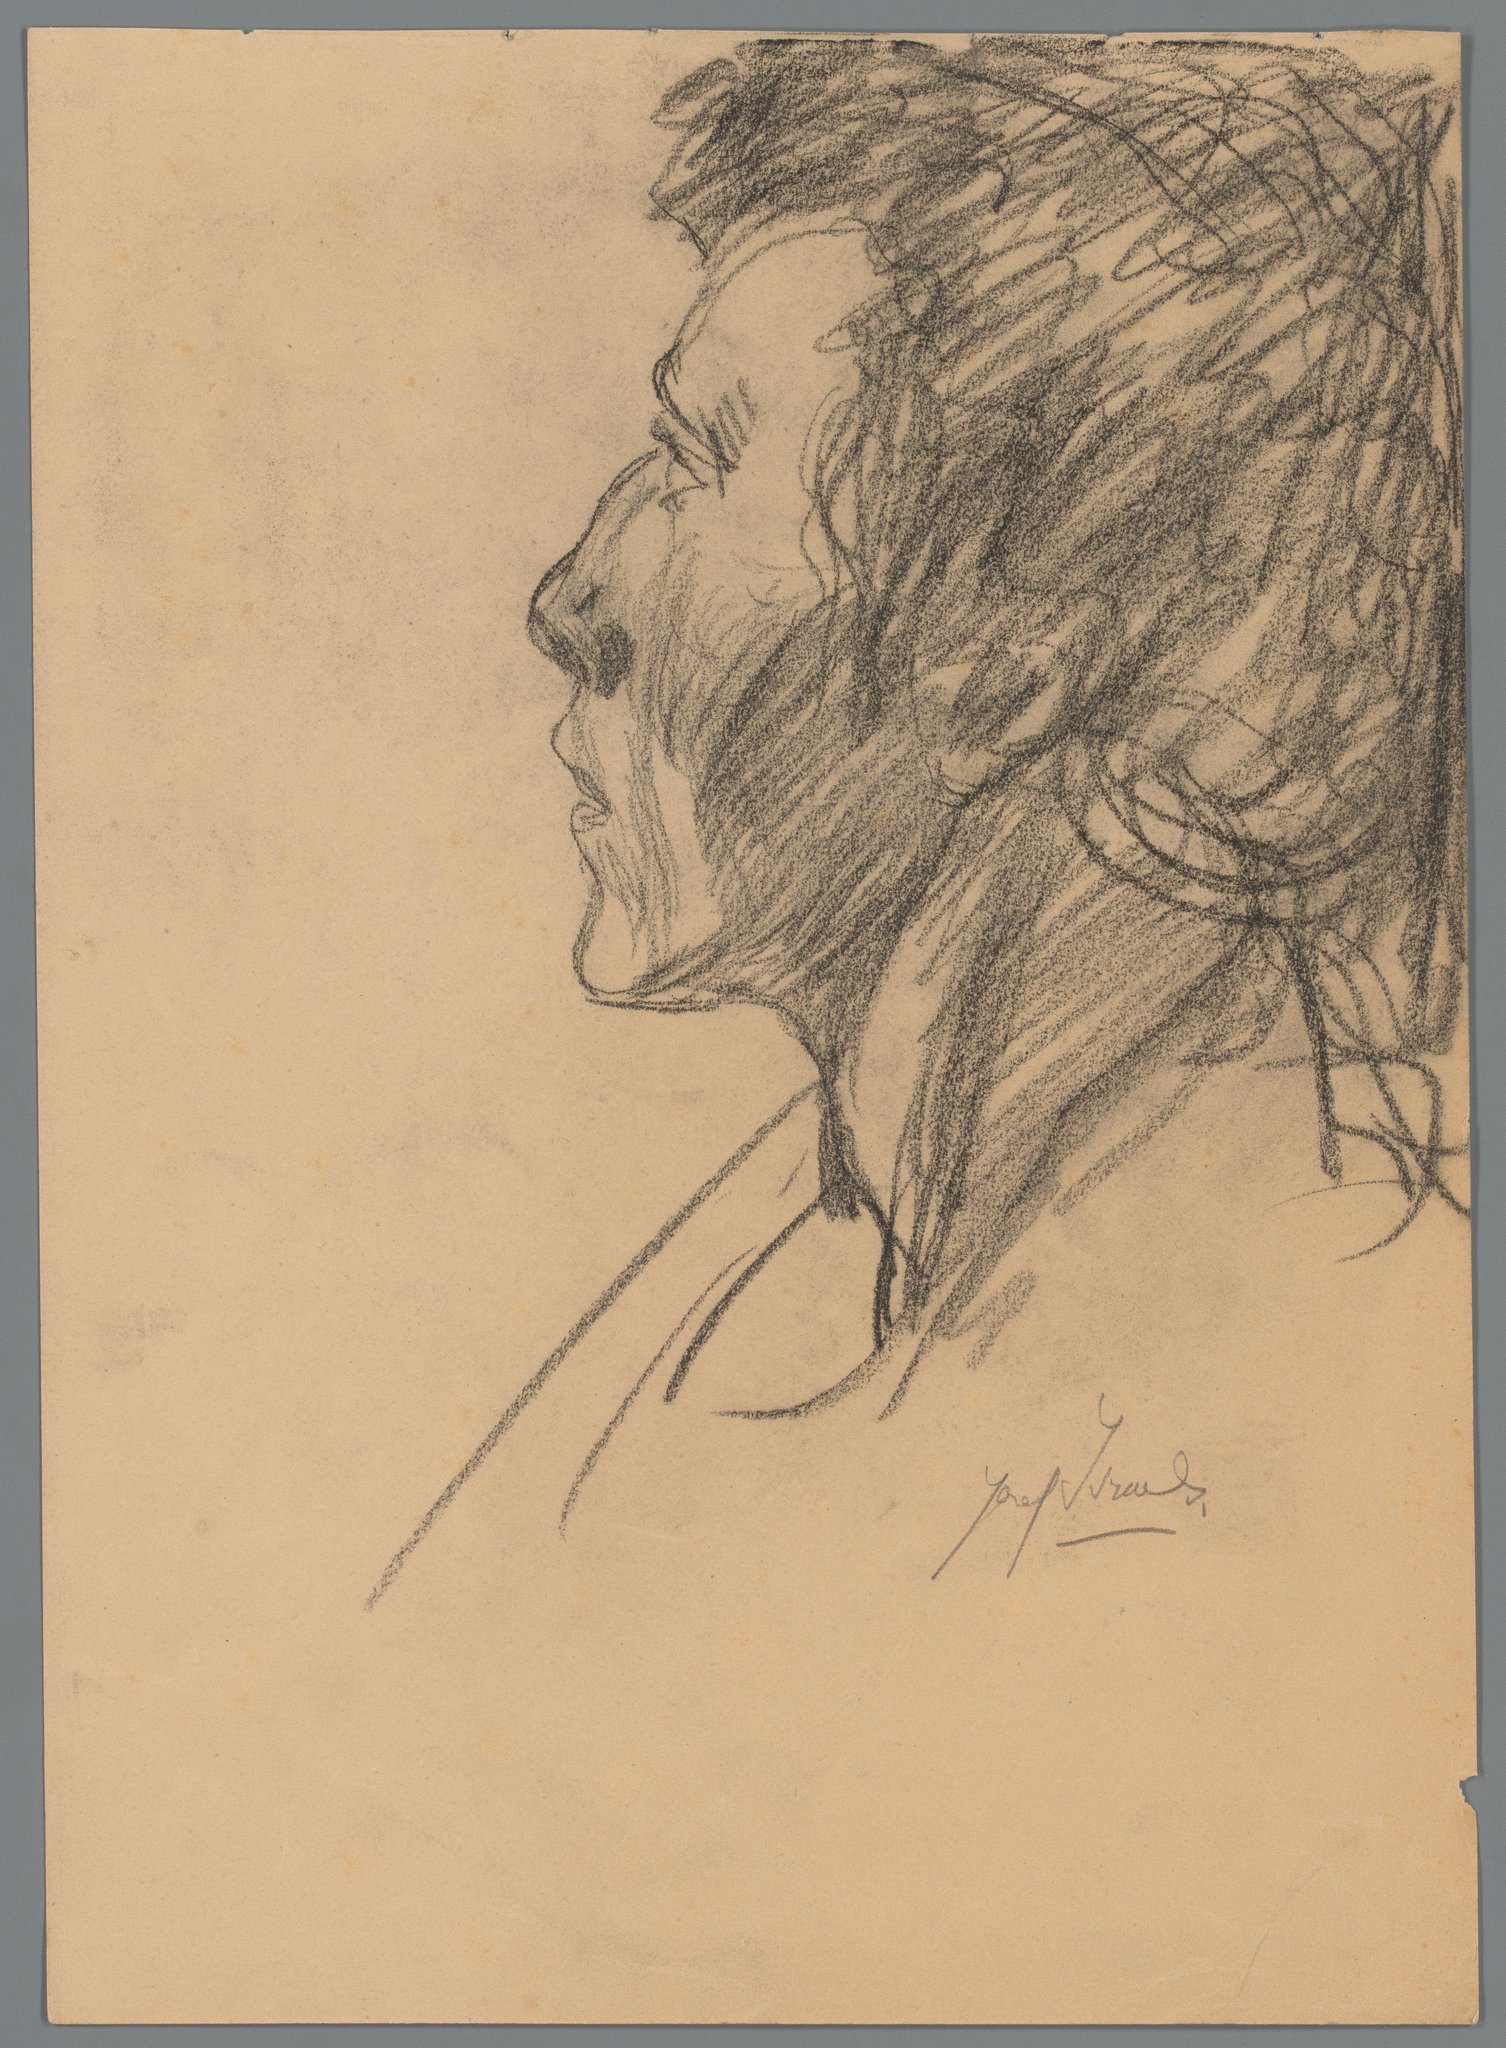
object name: drawing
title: Hoofd van David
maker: jozef israëls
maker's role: draughtsman, painter, print maker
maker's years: 1824-1911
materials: chalk, paper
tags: head (human), story of david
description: Voorstudie voor het schilderij 'David en Saul' dat zich in het Groninger Museum bevindt.